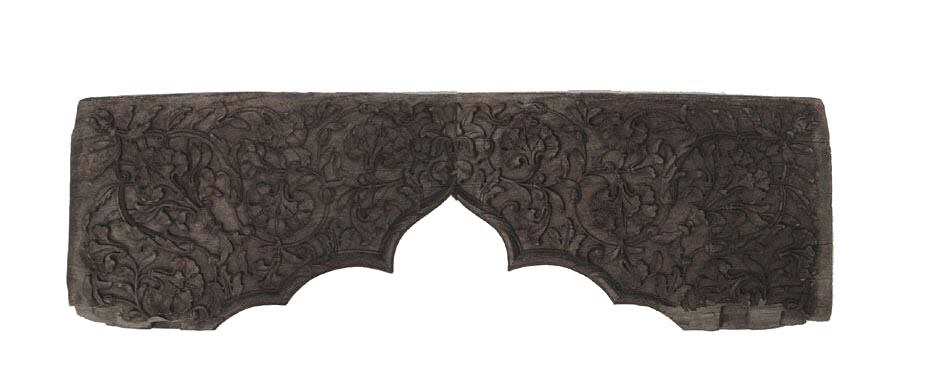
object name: archway section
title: Upper Section of an Arch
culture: indian, northern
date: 1667-1700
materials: wood